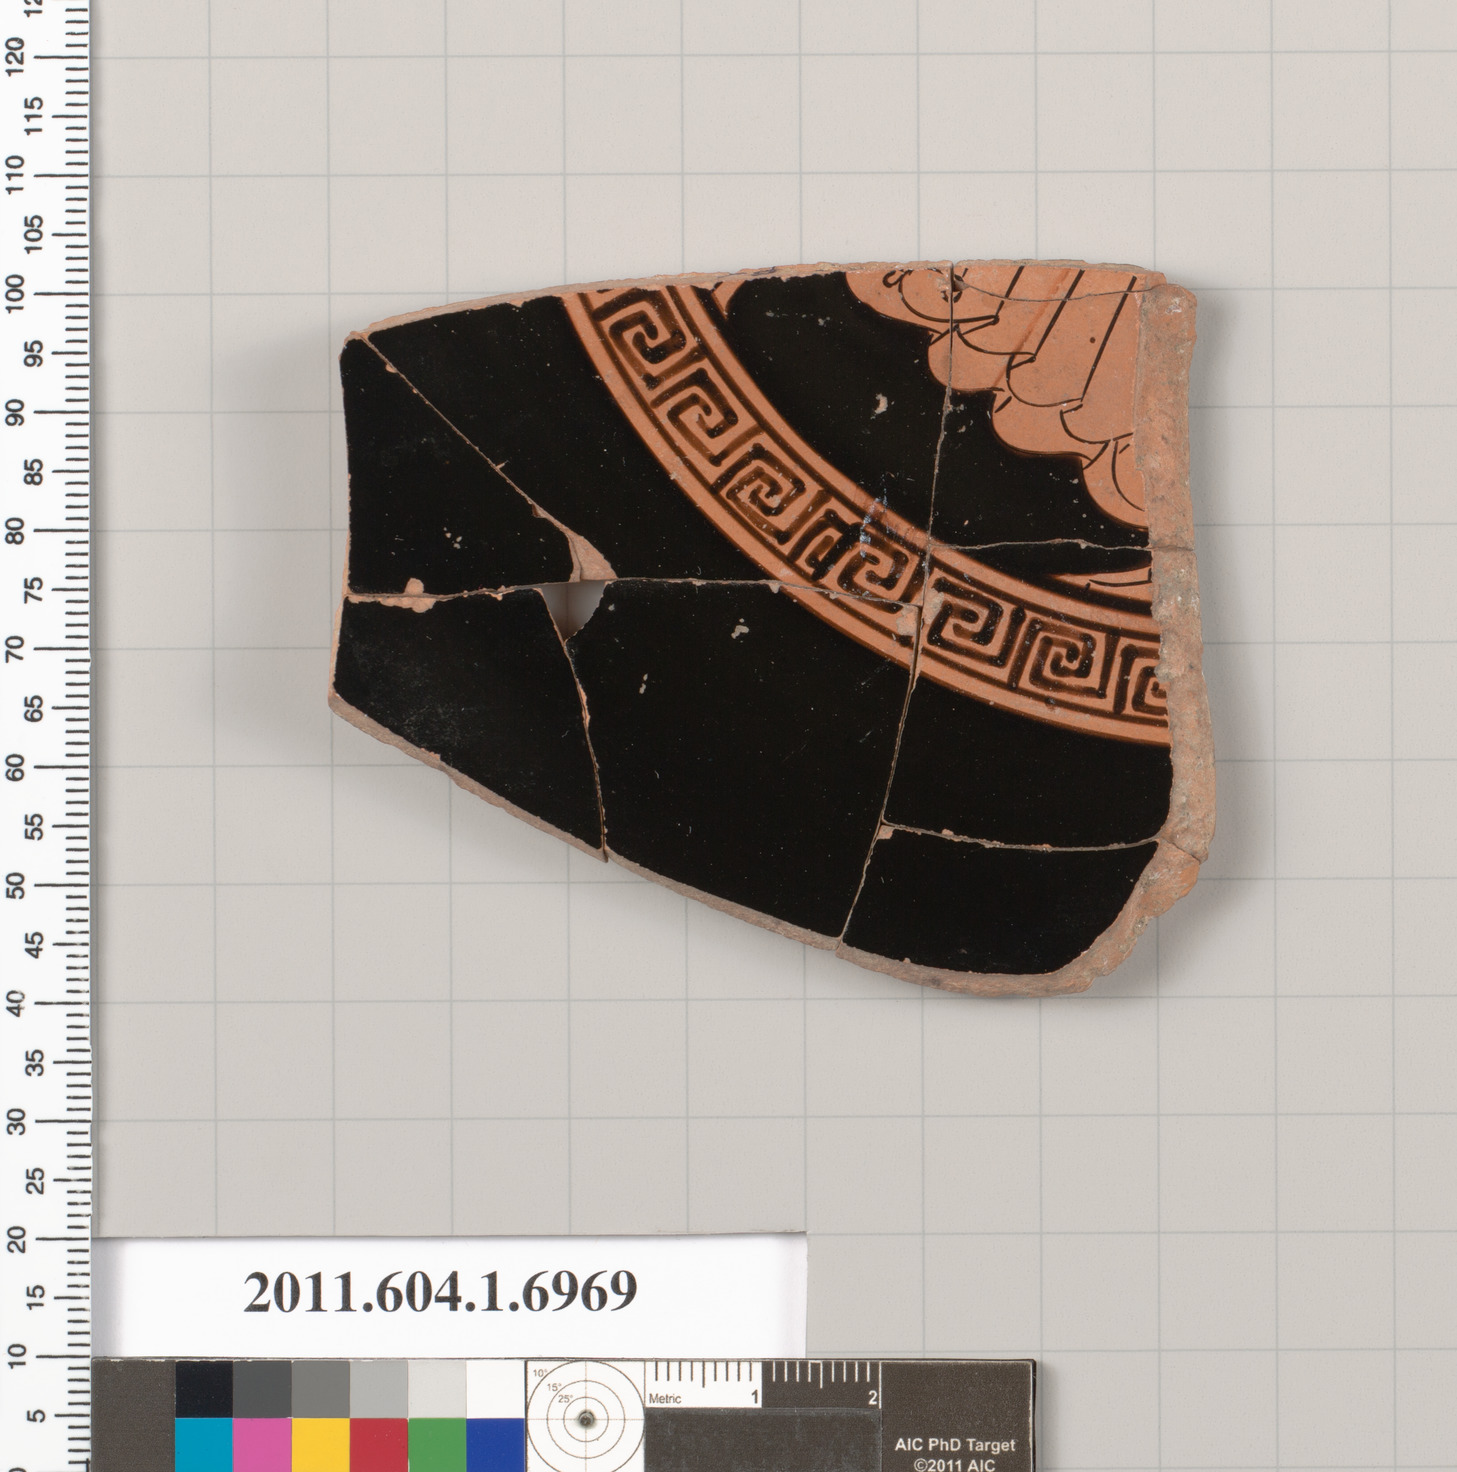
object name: kylix fragment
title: Terracotta fragment of a kylix (drinking cup)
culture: greek, attic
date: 490-470 BCE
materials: terracotta